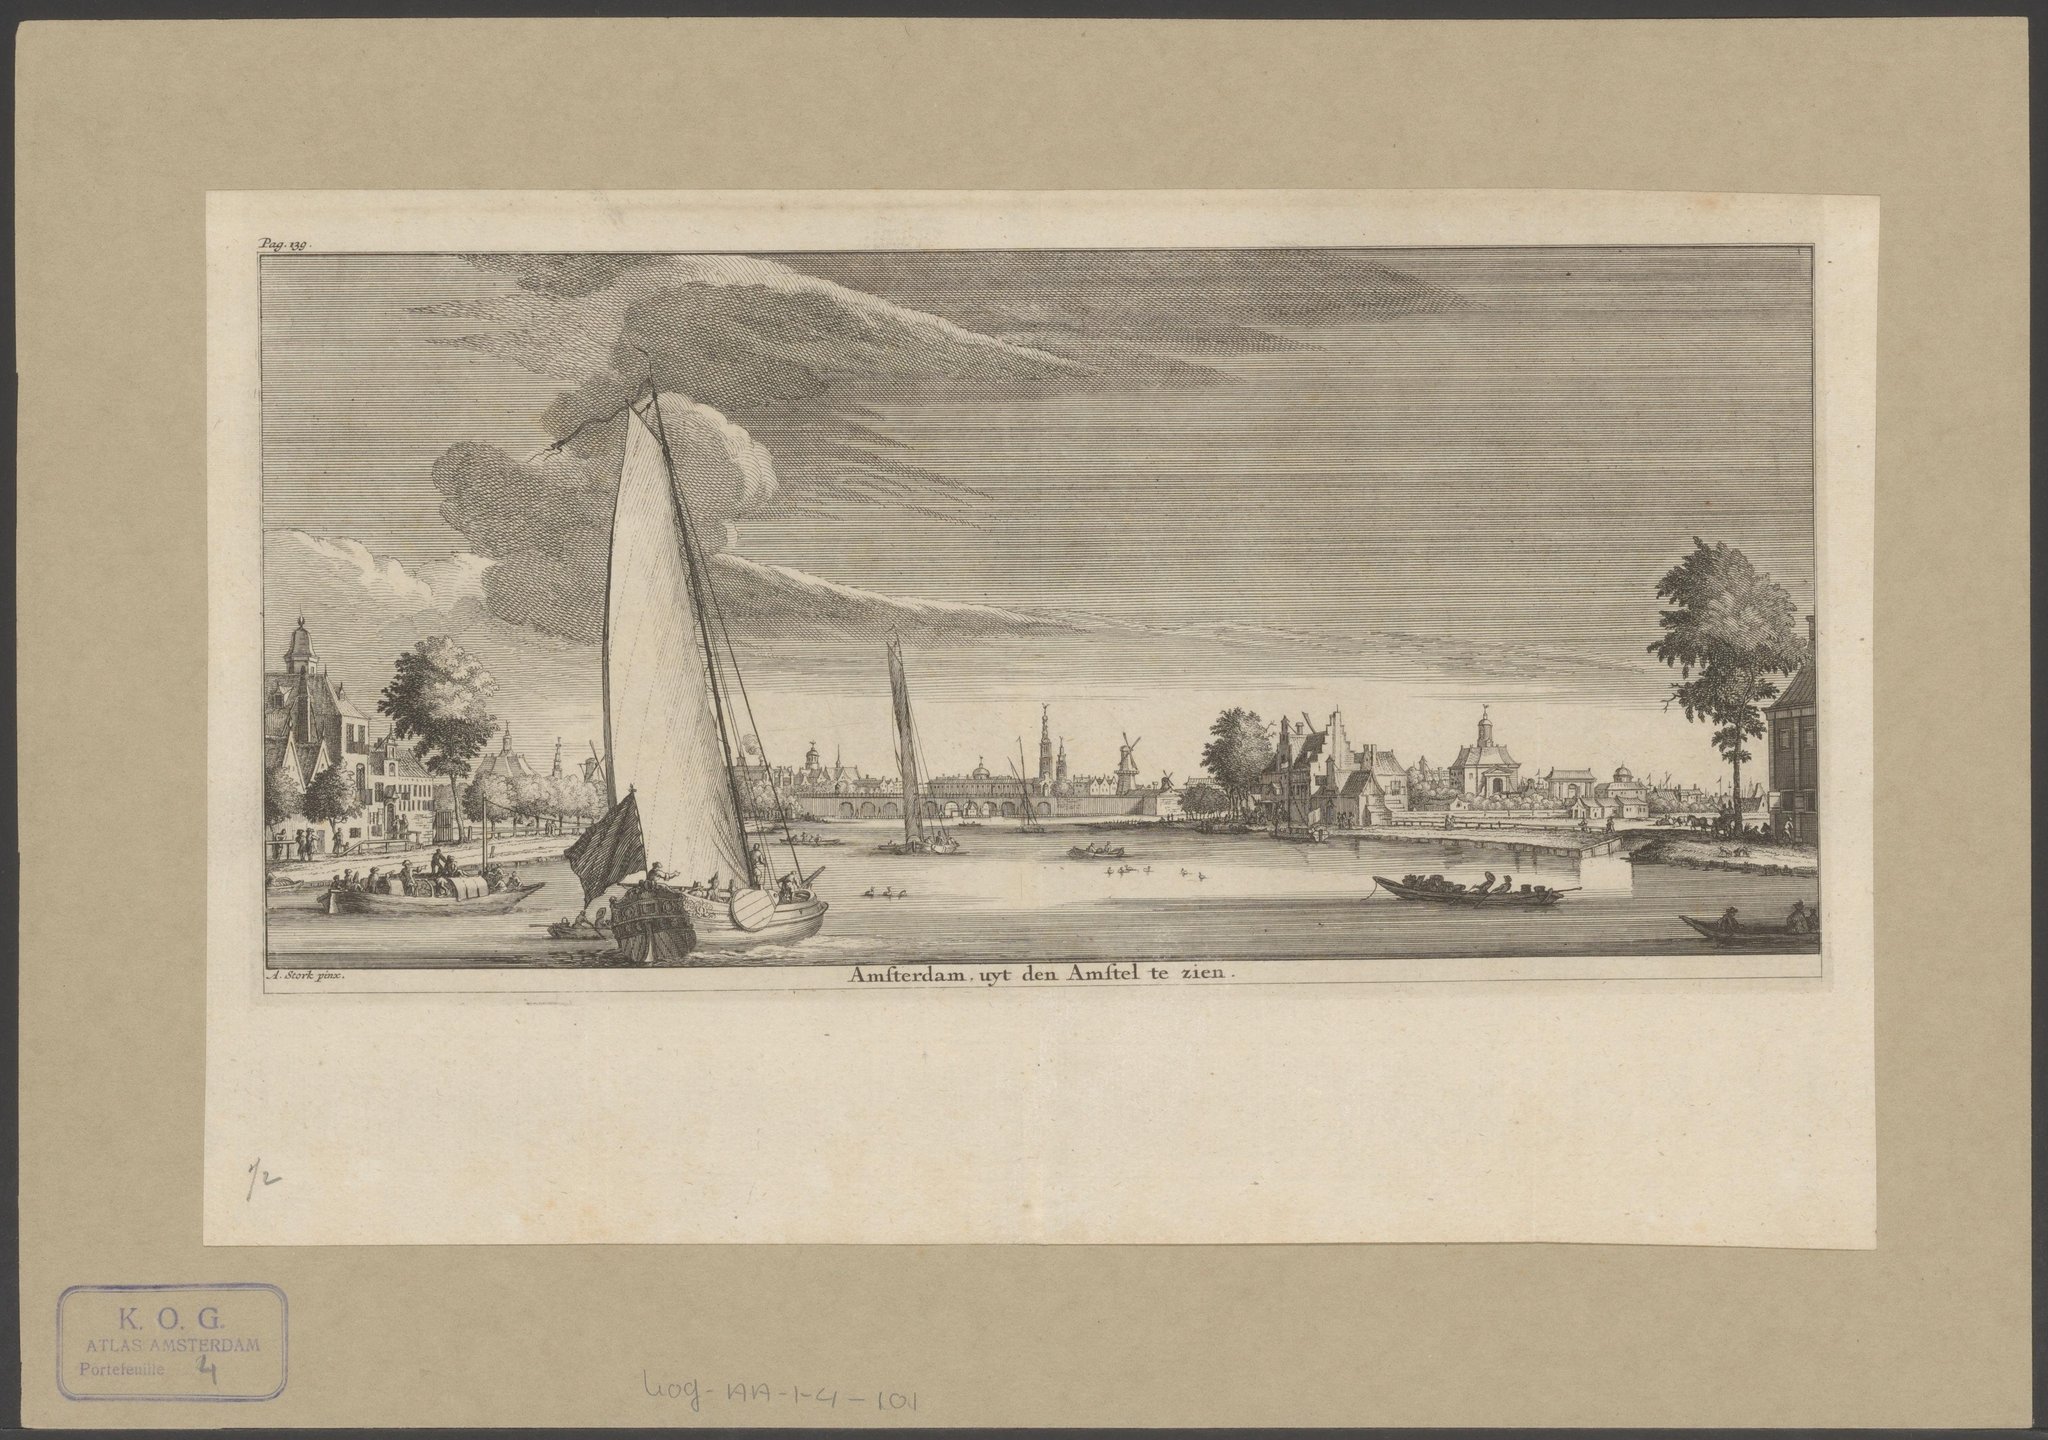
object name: print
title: Amsterdam, uyt den Amstel te zien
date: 1723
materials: paper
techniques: engraving, etching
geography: amsterdam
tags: sailing-ship, sailing-boat, city-view in general; 'veduta', river, bridge in city across river, canal, etc., amsterdam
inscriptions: collector's mark: ‘4’ Lugt 1641b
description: Prent waarschijnlijk uit: Willink, Daniël. Amsterdamsche Buitensingel nevens de omleggende dorpen, opgeheldert door aanteekeningen over veele voornaame geschiedeniszen: met afbeeldingen (…) / Daniël Willinks Amsterdamsche Buitensingel. Amsterdam: Andries van Damme, 1723. En in: Willink, Daniël. Amsterdamsche Buitensingel nevens de omleggende dorpen, opgeheldert door aanteekeningen over veele voornaame geschiedenissen: met afbeeldingen (…) / Daniël Willinks Amsterdamsche Buitensingel. Amsterdam: Arend van Huyssteen, 1738.